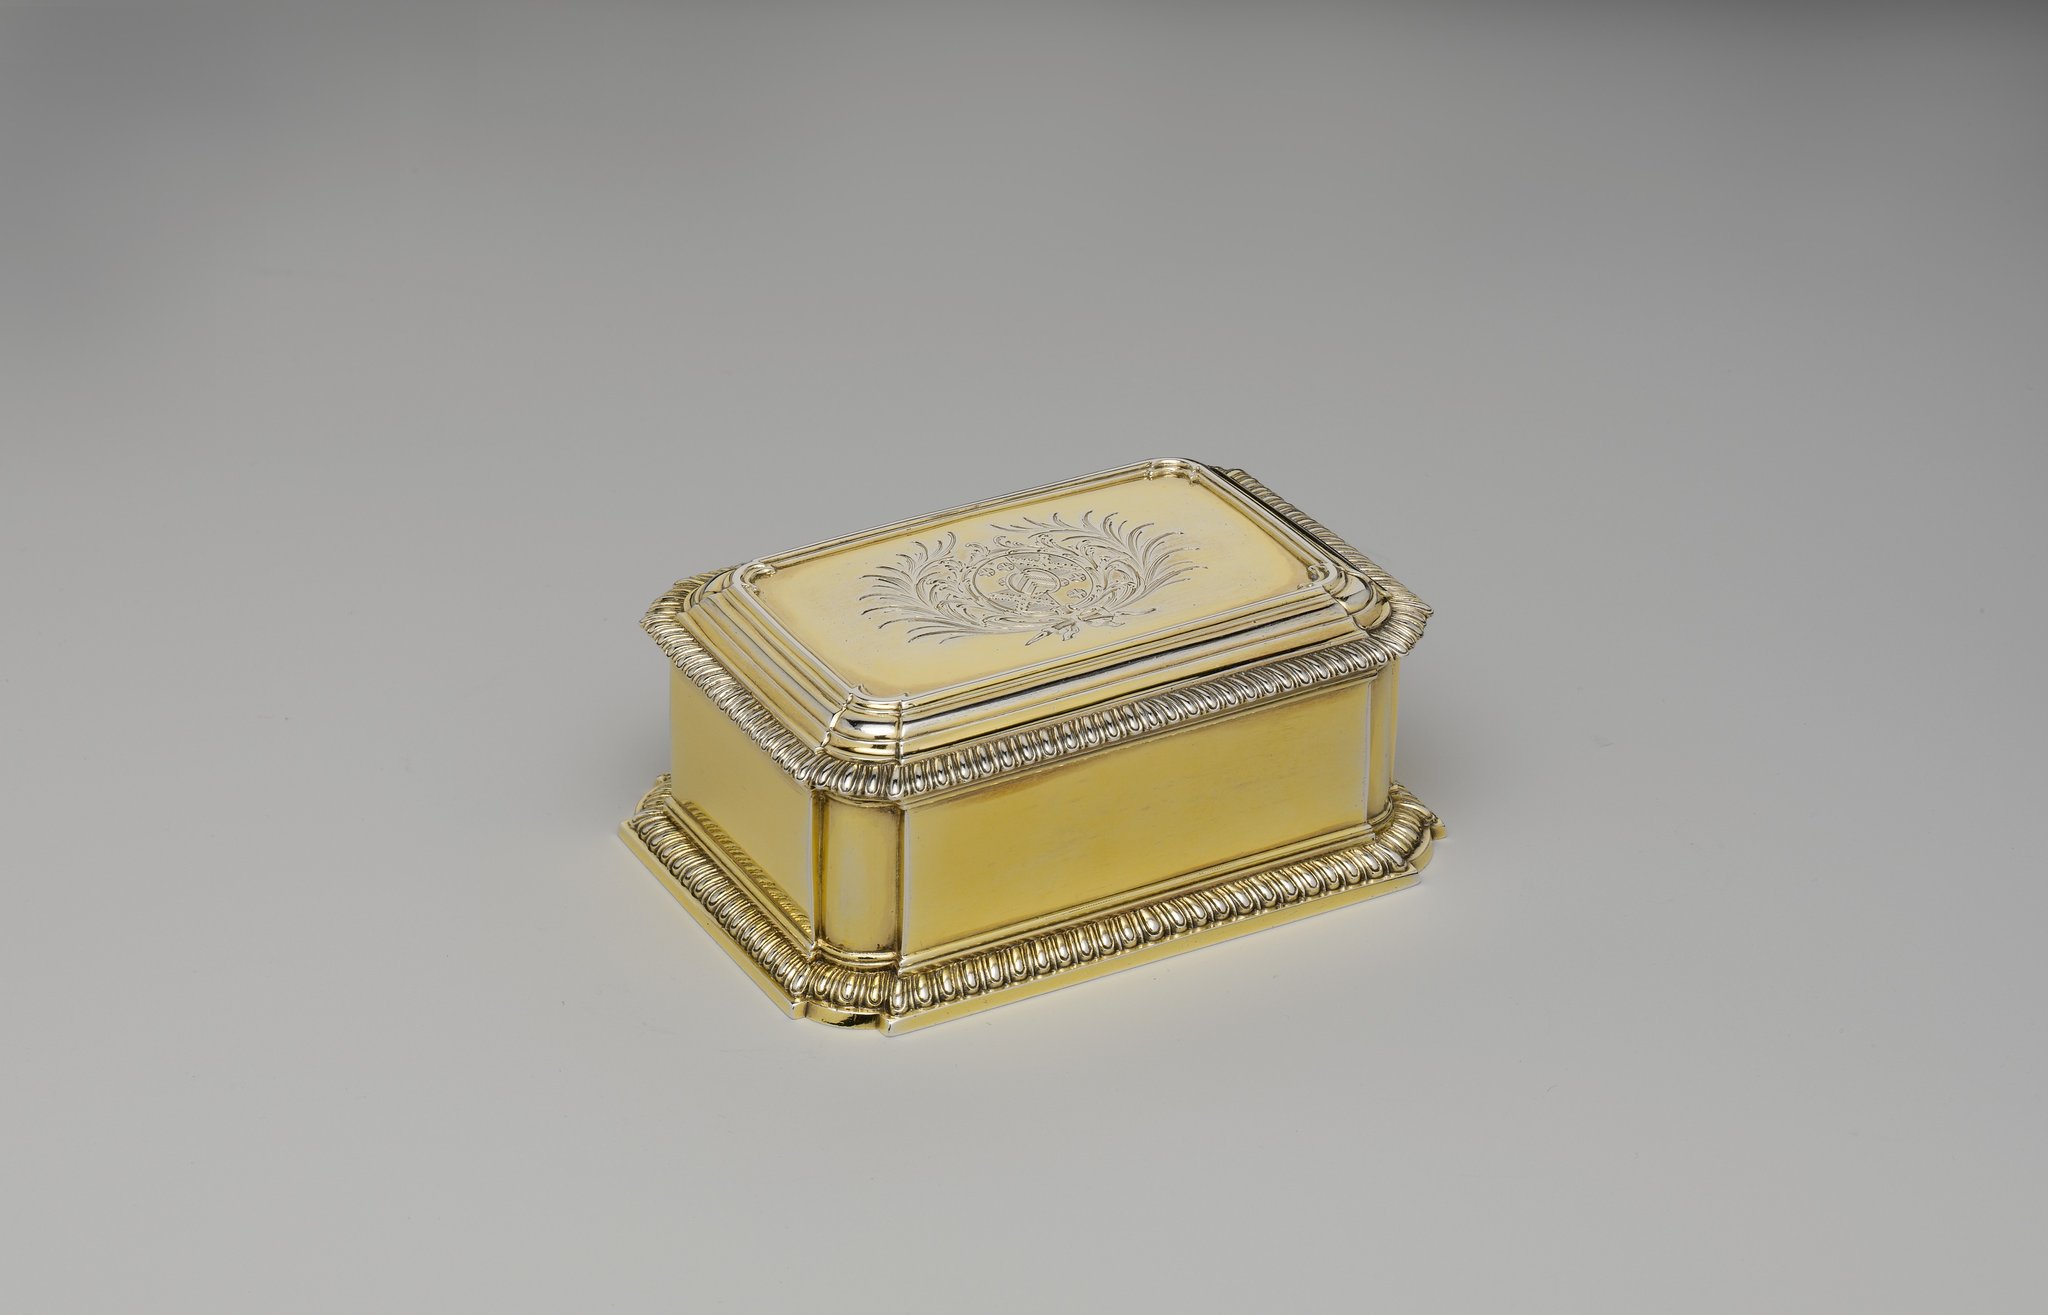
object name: toilet box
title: Toilet box (one of a pair) (part of a set)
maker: john parker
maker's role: maker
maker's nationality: british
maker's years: 1759-1777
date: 1766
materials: silver gilt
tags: insignia